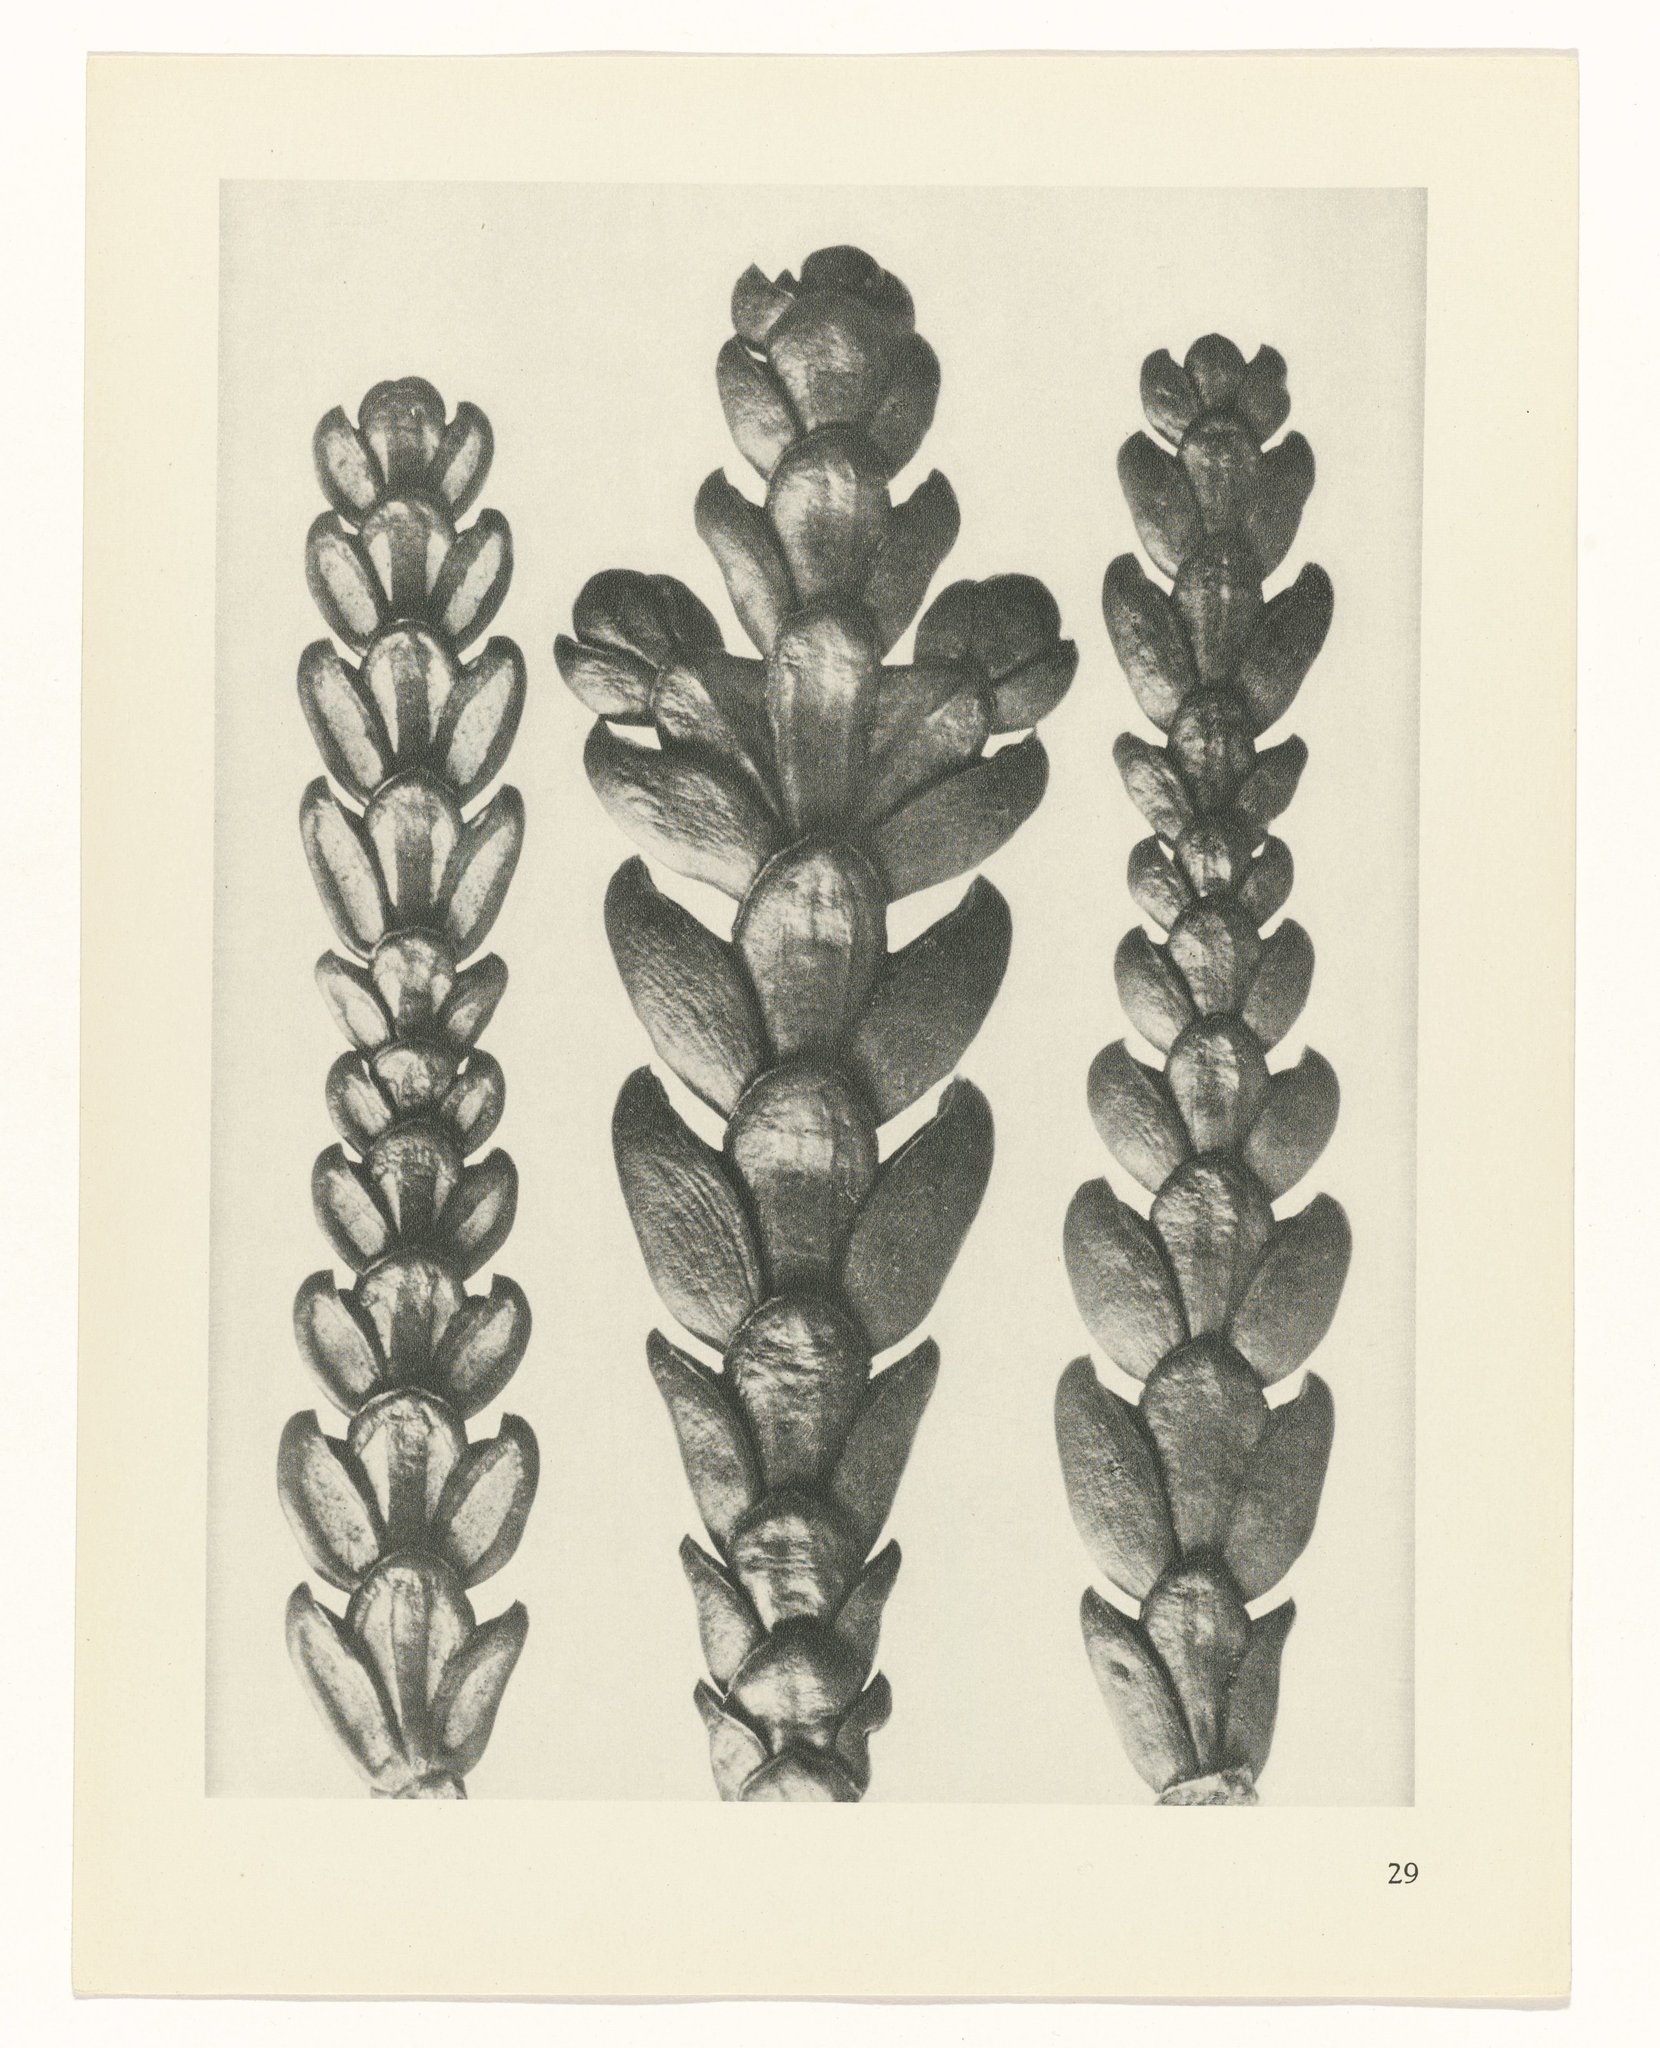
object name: photograph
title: Urformen der Kunst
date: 1928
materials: ink, paper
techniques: rotogravure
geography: berlin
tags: plants (in general)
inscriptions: number: ‘29’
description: facher Vergrößerung. Afkomstig uit losbladige uitgave.